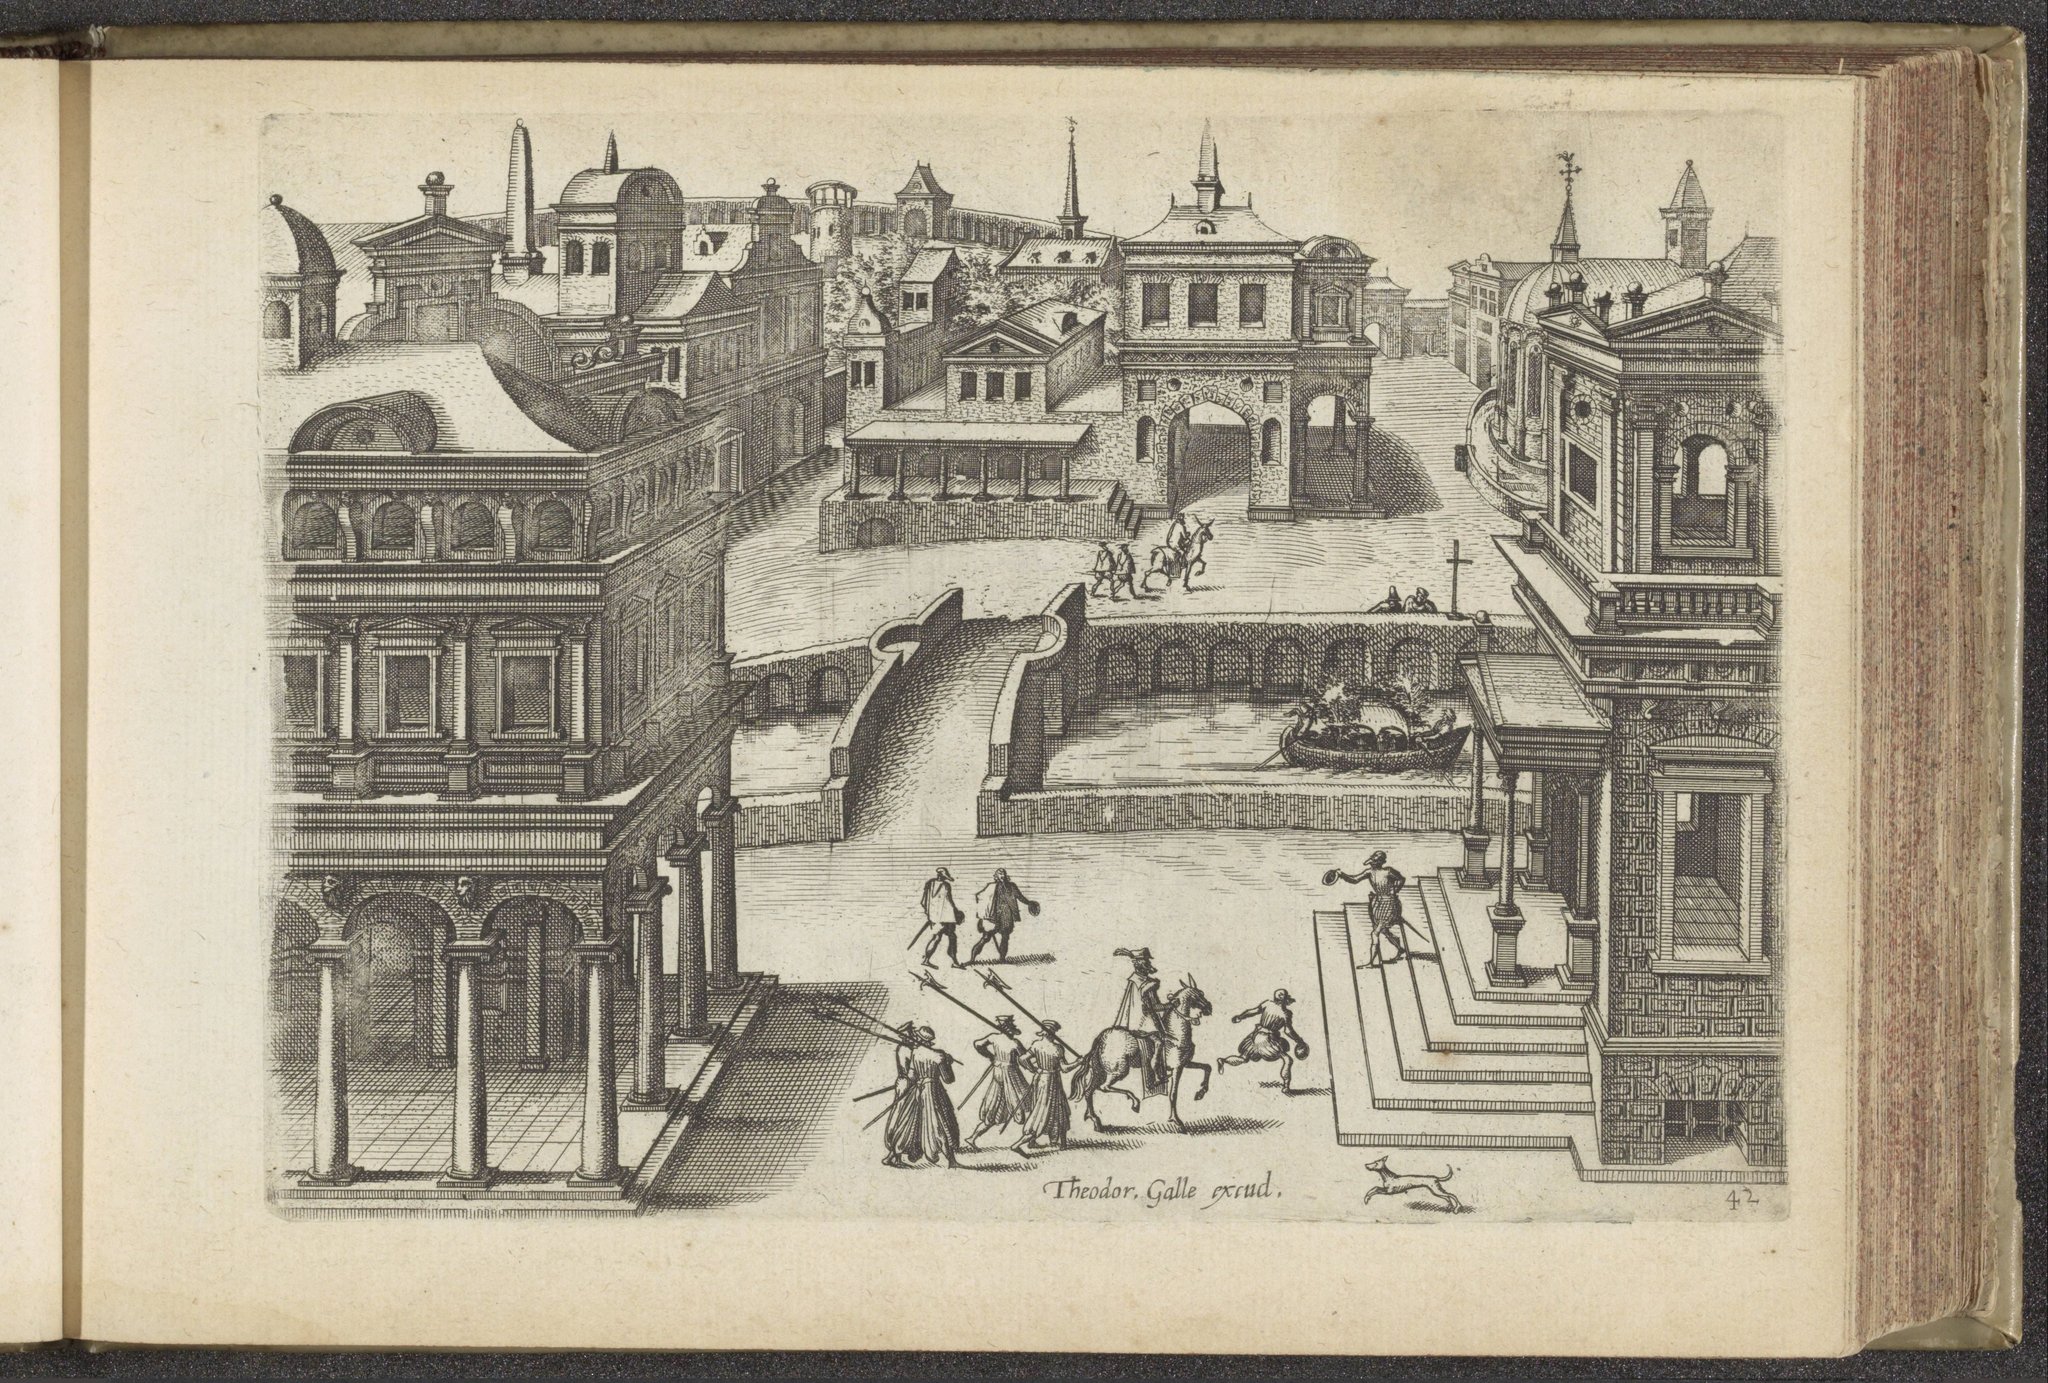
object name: print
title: Variae Architecturae formae (...)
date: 1562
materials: paper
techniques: etching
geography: antwerp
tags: city-view, and landscape with man-made constructions, architectural representations in general, canal, palace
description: Gezicht op een stad met paleizen en een kanaal in vogelvluchtperspectief. Vanaf de trappen van het gebouw rechts begroet een man een ruiter. Deze prent maakt deel uit van een album.